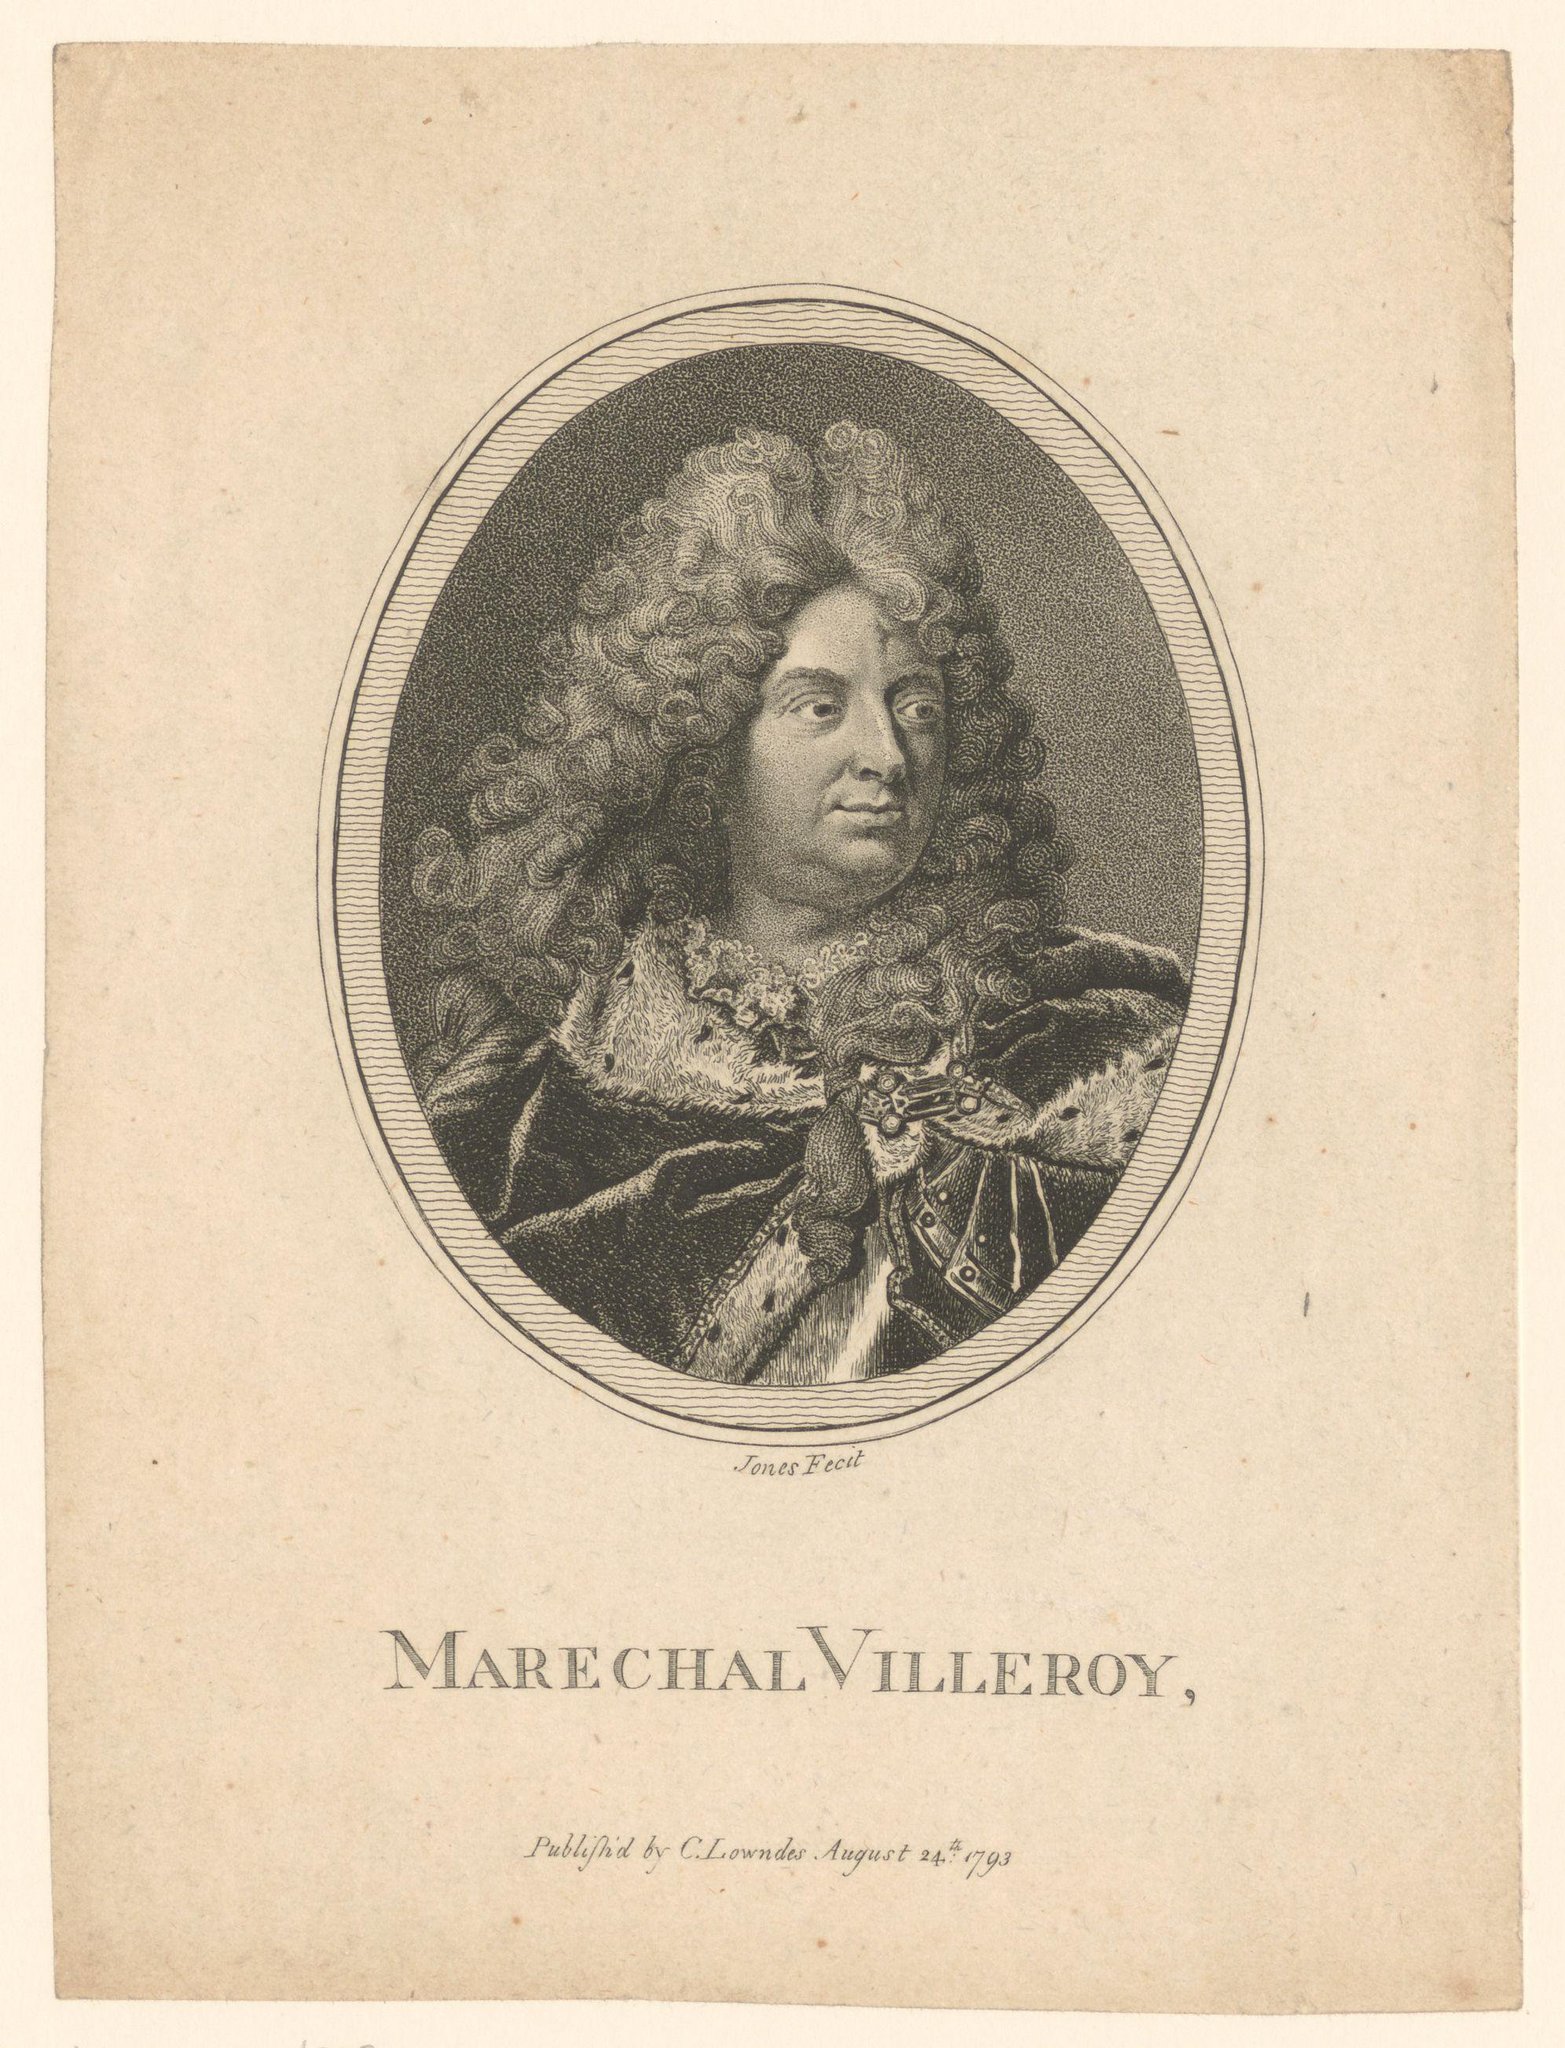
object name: print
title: Portret van François de Neufville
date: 1793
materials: paper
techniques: etching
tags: lyon, paris, françois de neufville (hertog van villeroy), historical persons, officer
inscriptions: collector's mark: Lugt 2228